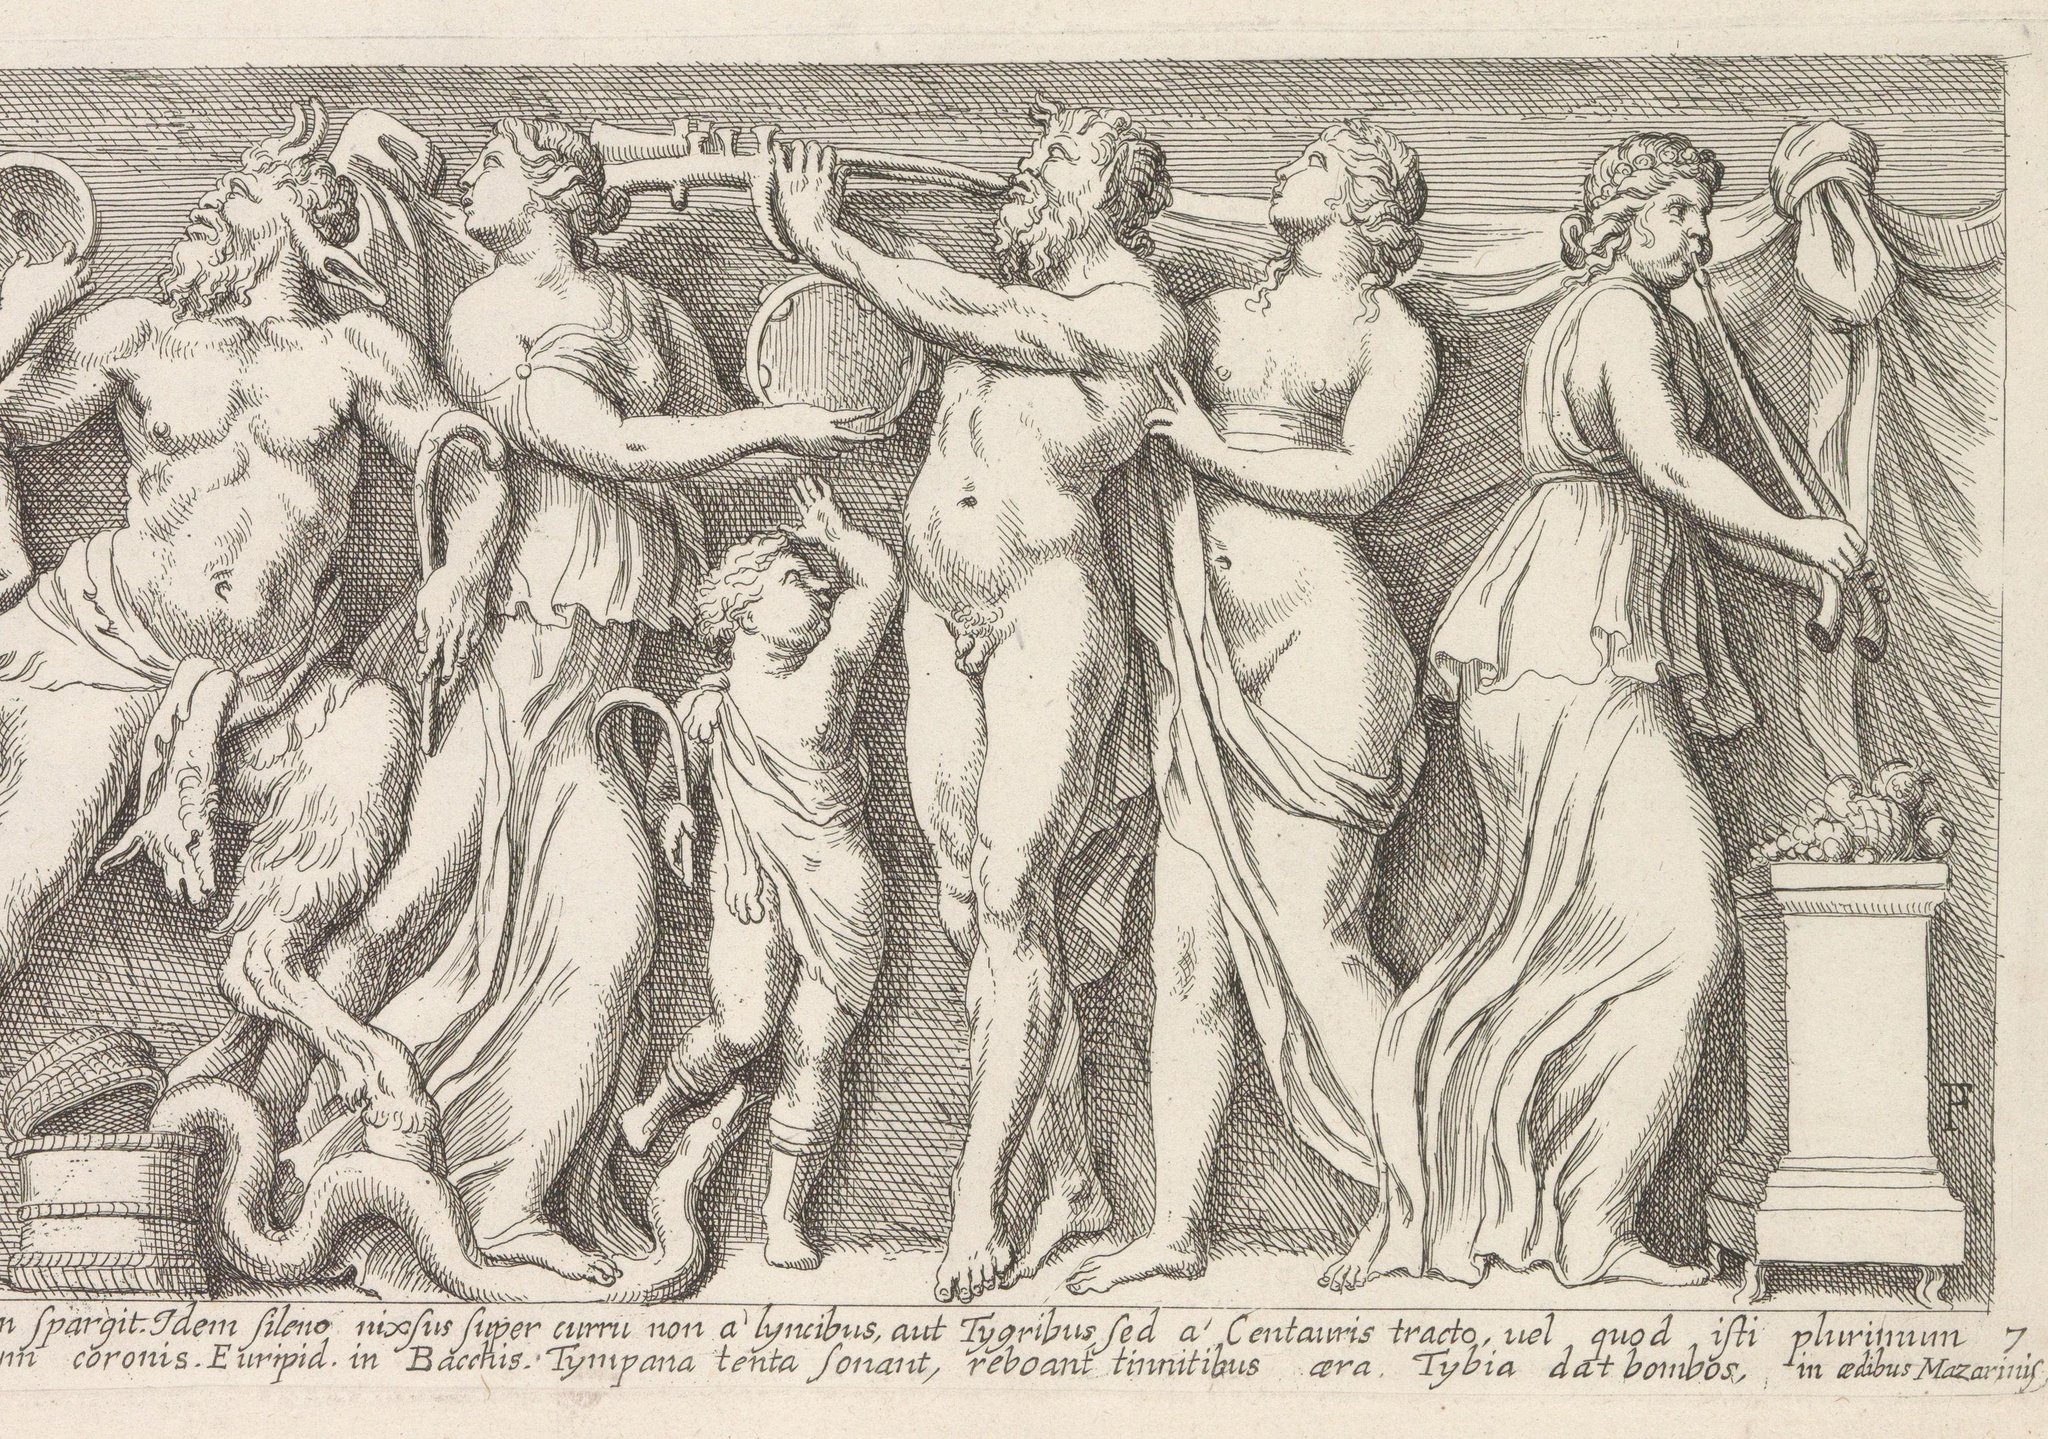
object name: print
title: Icones et segment (...)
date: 1645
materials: paper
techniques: etching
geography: paris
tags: triumph of bacchus; 'carro di bacco' (ripa), maenad(s), female bacchant(es), piece of sculpture, reproduction of a piece of sculpture, satyr(s) (in general)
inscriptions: number: ‘34’, inscription: ‘Ende lib. No. 5. fol. 76.’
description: Deze prent maakt deel uit van een reeks van 54 prenten (+ titelprent) naar antieke reliëfs. De nummering op de prenten loopt van 1 tot en met 50. Sommige prenten hebben dubbele nummers. Naar een reliëf in Palazzo Rospigliosi-Pallavicini te Rome.